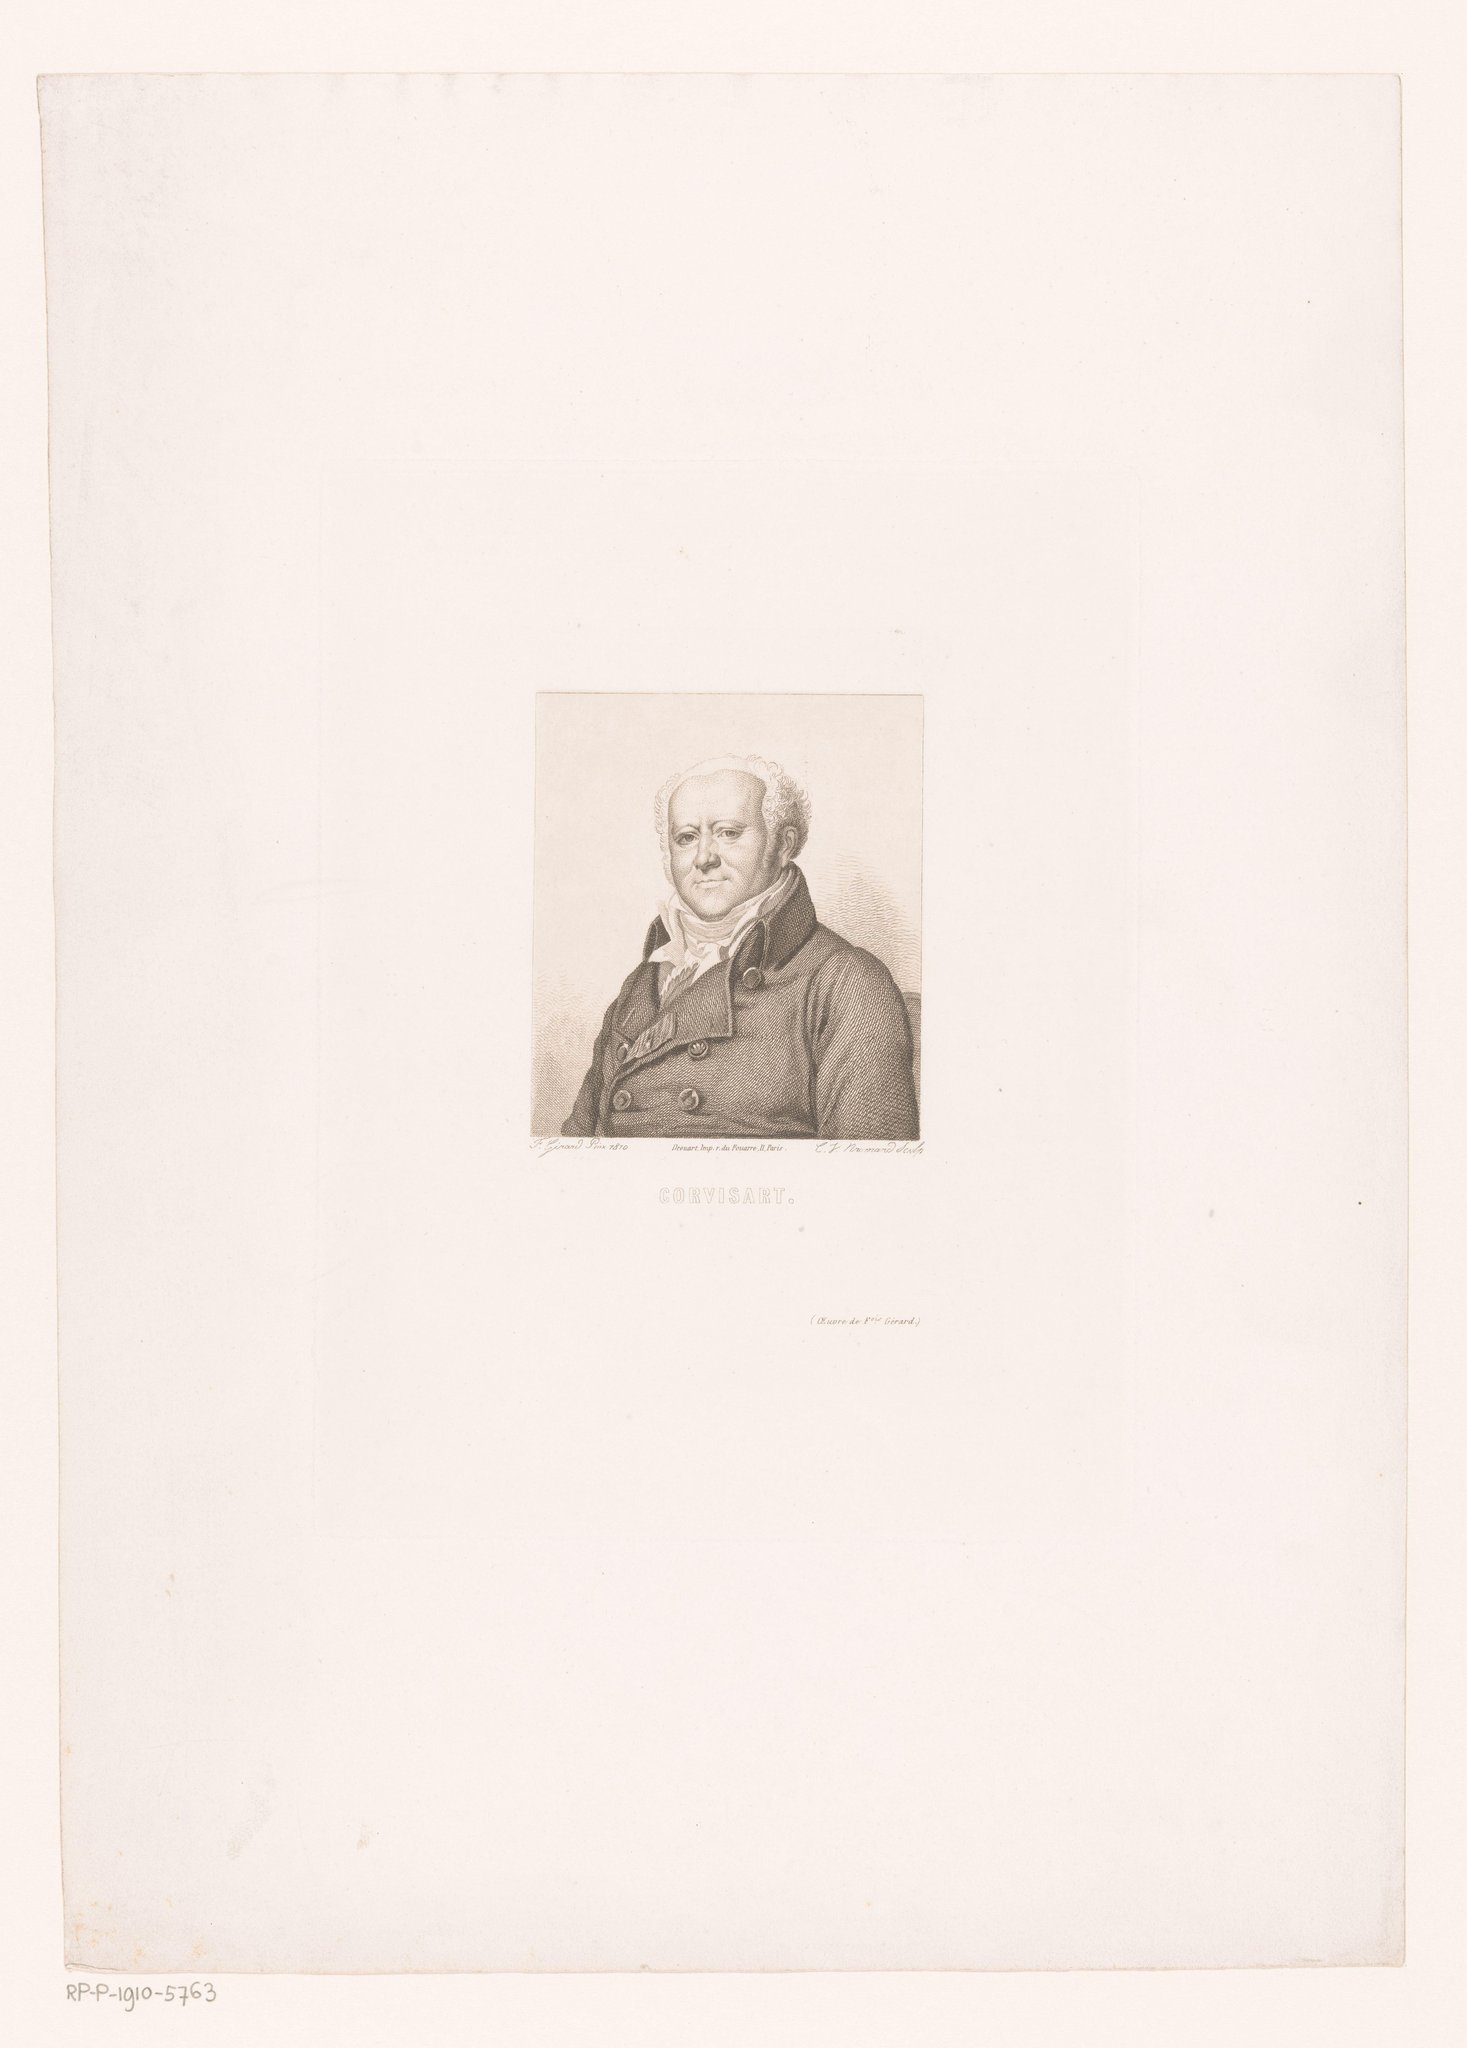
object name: print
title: Portret van Jean-Nicolas Corvisart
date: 1824-1910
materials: paper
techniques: etching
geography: paris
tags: historical persons, physician, doctor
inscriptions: collector's mark: Lugt 2228